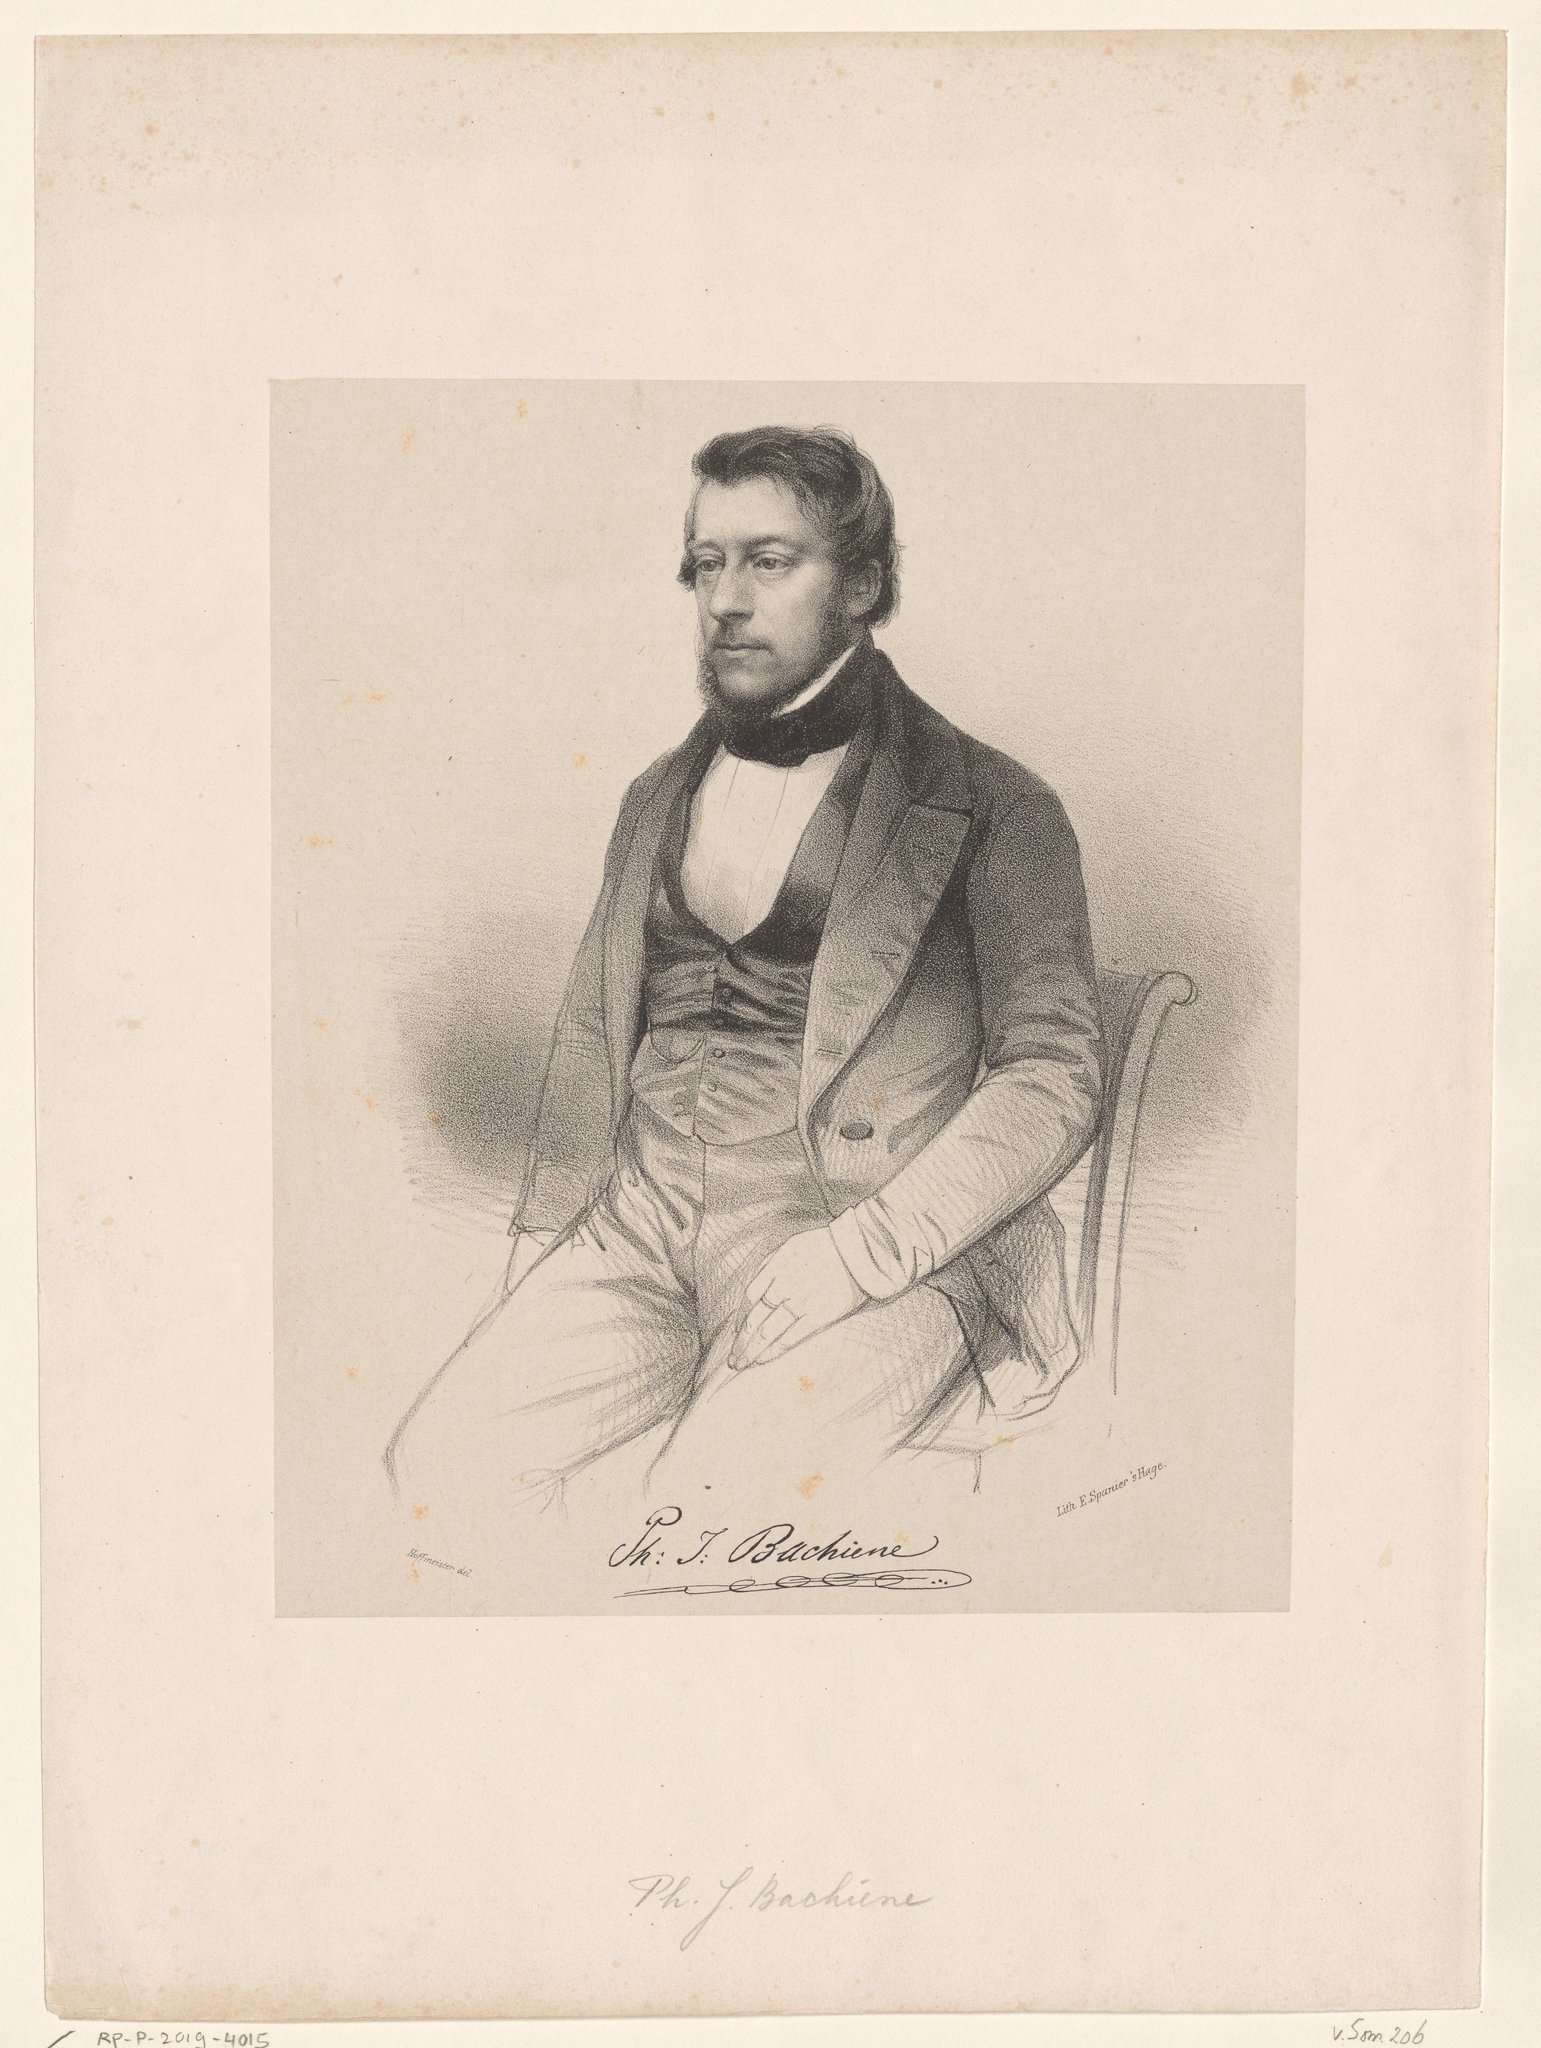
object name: print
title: Portret van Philippus Johannes Bachiene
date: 1843-1863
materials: paper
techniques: lithograph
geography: the hague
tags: the hague, official, historical persons